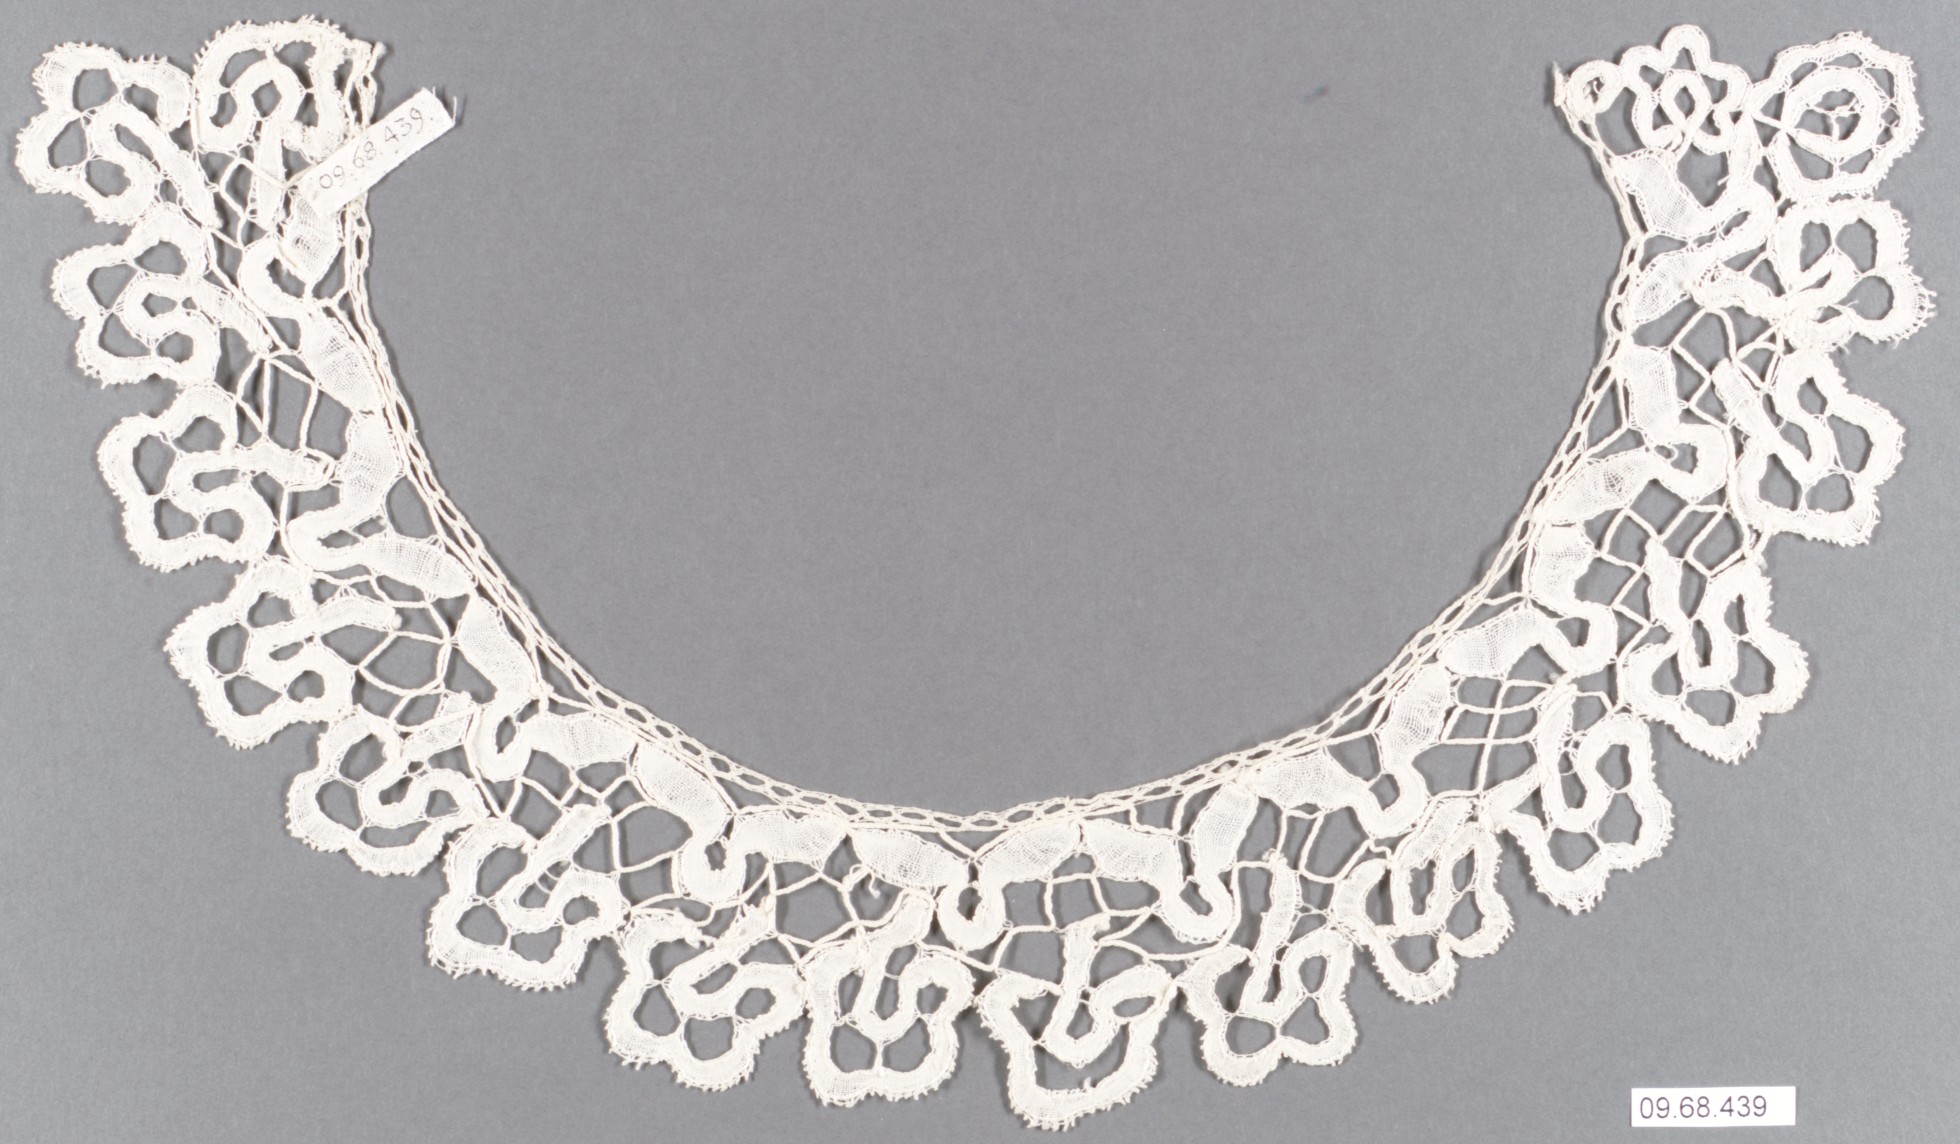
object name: collar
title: Collar lace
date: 1801-1900